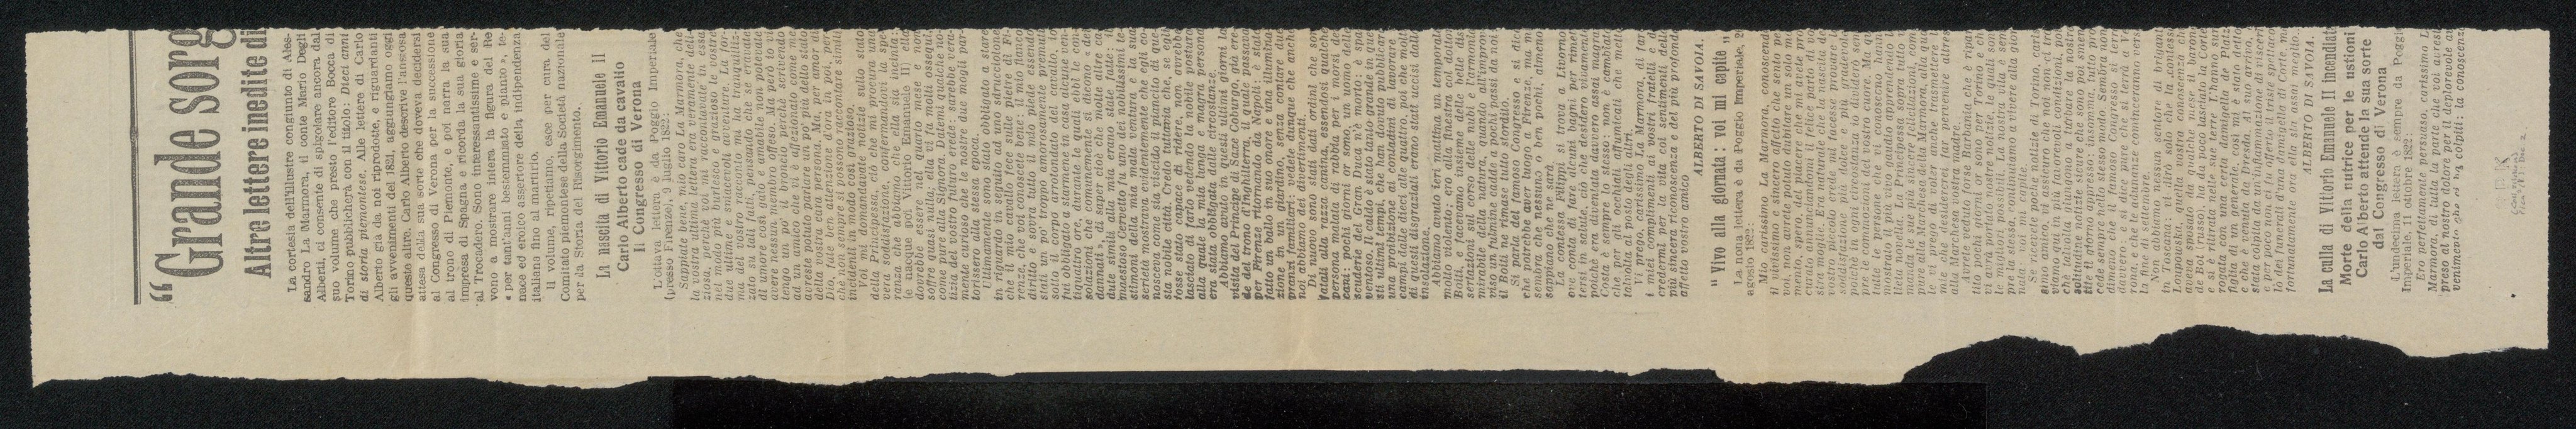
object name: newspaper clipping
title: Krantenknipsel uit archief Philip Zilcken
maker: Anonymous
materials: paper, ink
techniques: printing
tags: naples, vittorio pica, draughtsman, philip zilcken, printed matter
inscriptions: collector's mark: ‘RPK’